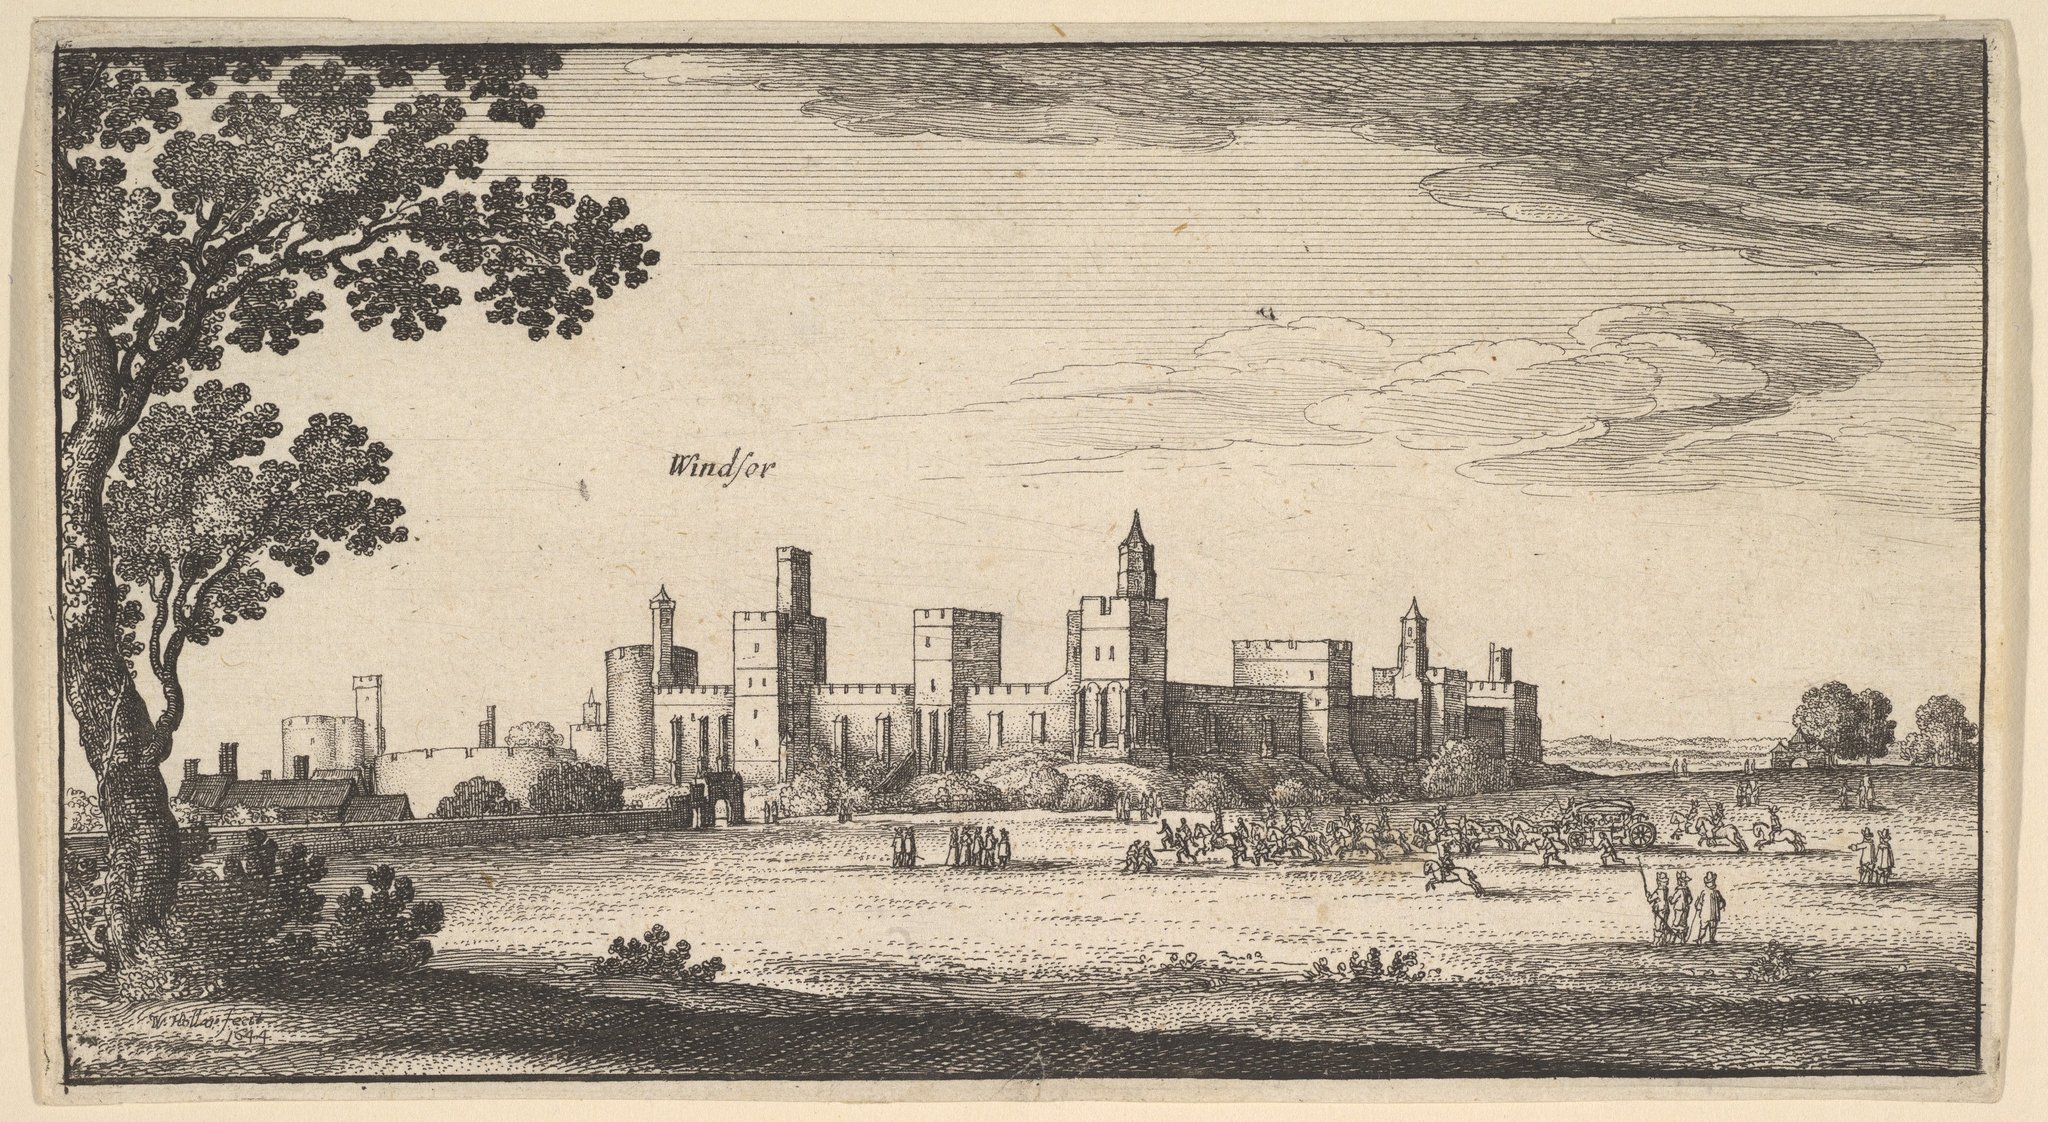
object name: print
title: Windsor Castle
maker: wenceslaus hollar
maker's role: artist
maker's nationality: bohemian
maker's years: 1607-1677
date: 1644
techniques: etching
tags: castles